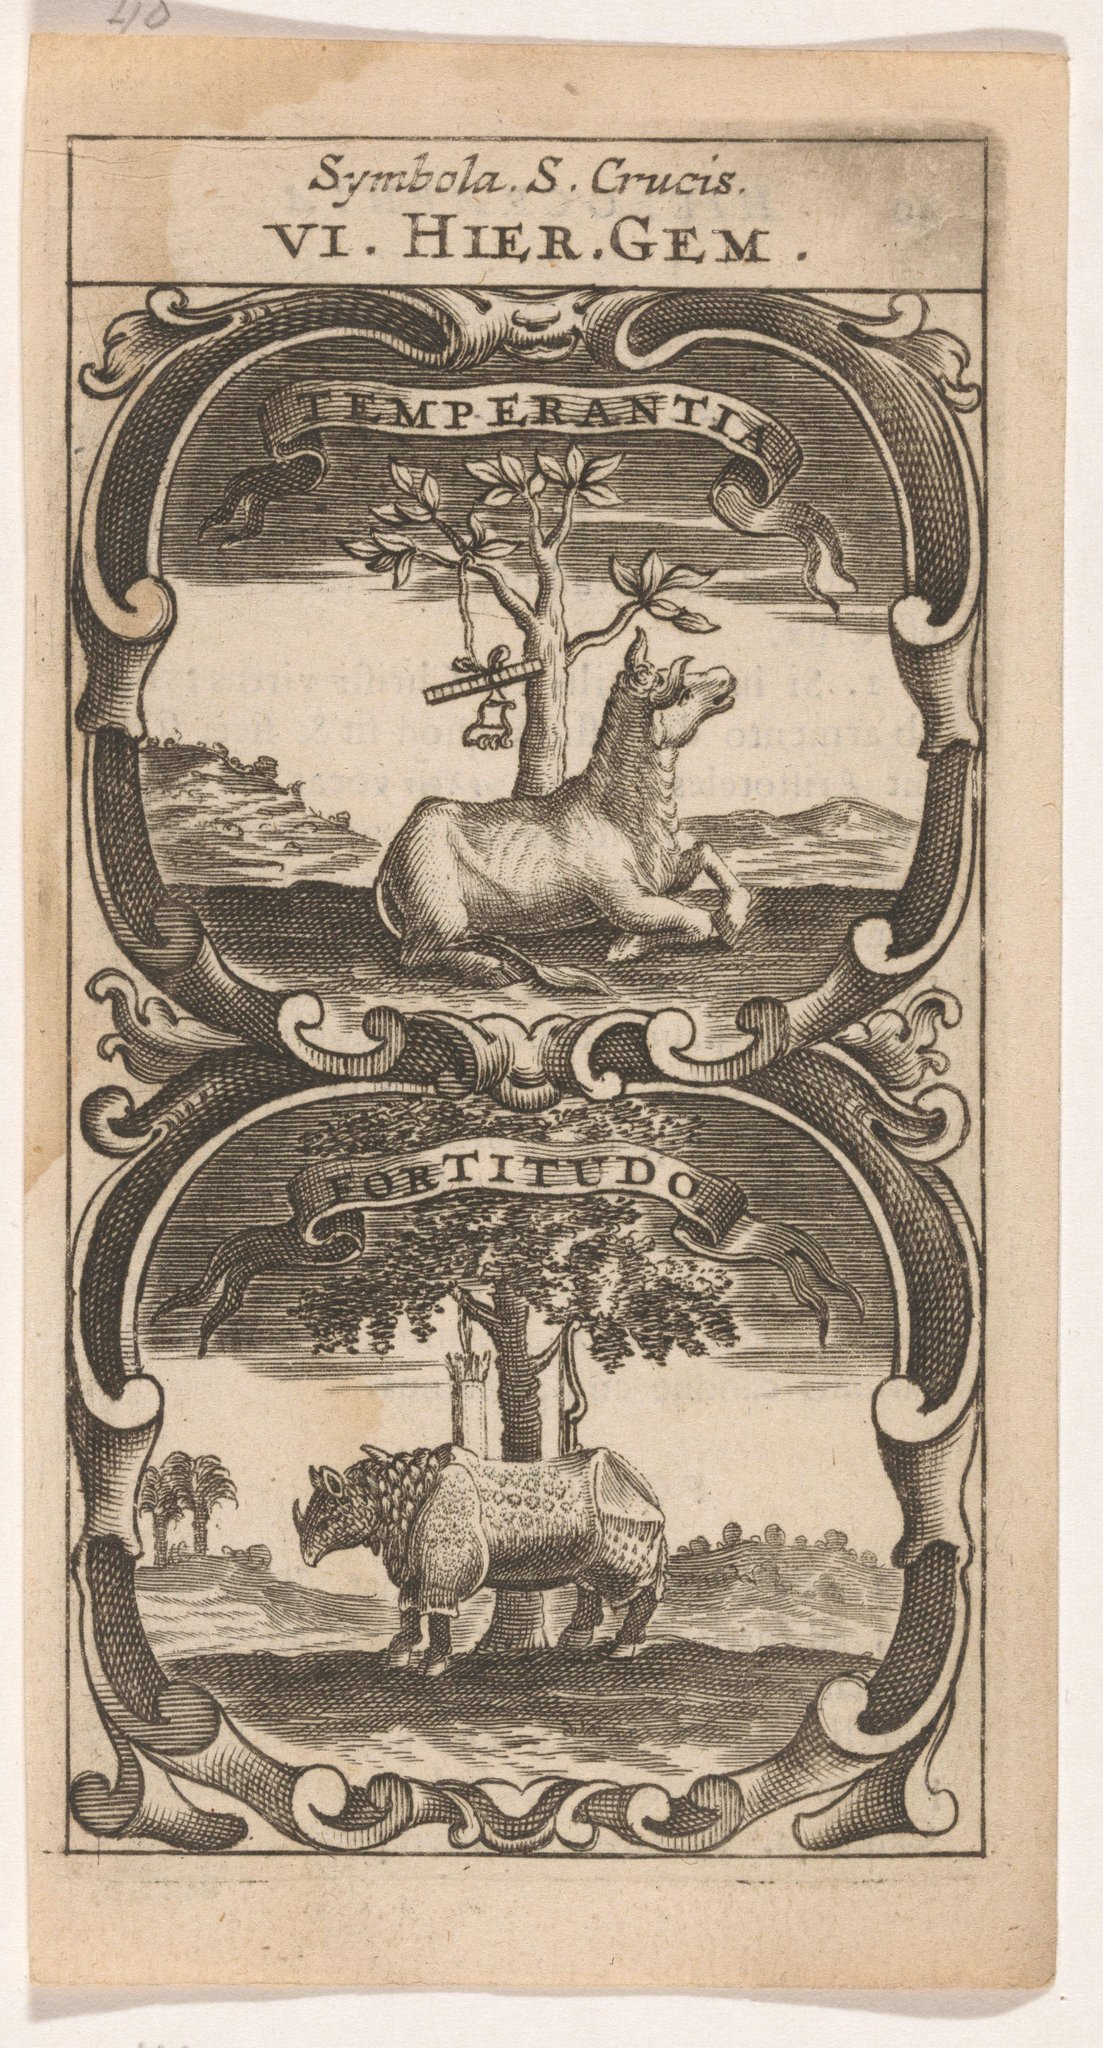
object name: book illustration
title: Temperantia / Fortitudo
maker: Anonymous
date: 1666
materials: paper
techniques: engraving, letterpress printing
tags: fortitude, 'fortitudo' ~ one of the four cardinal virtues, temperance, 'temperantia'; 'temperanza' (ripa) ~ one of the four cardinal virtues, hoofed animals: rhinoceros, ox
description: Pagina uit Jacob Typotius, Symbola Divina & Humana Pontificum Imperatorum Regum. Arnhem, J.F. Hagen, 1666 of uit de titeluitgave van 1669 of 1679. Het werk van Typotius werd voor het eerst uitgegeven in 1601 met prenten van Aegidius Sadeler.